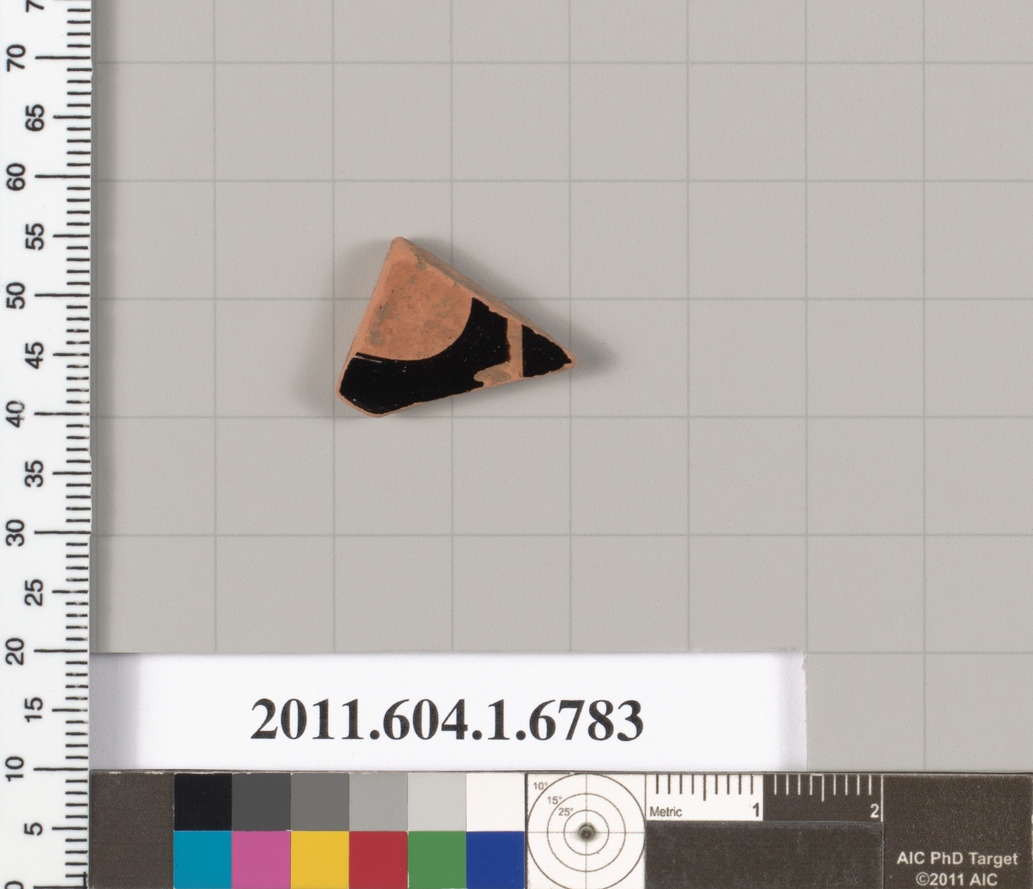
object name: kylix fragment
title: Terracotta fragment of a kylix (drinking cup)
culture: greek, attic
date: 490-470 BCE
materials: terracotta